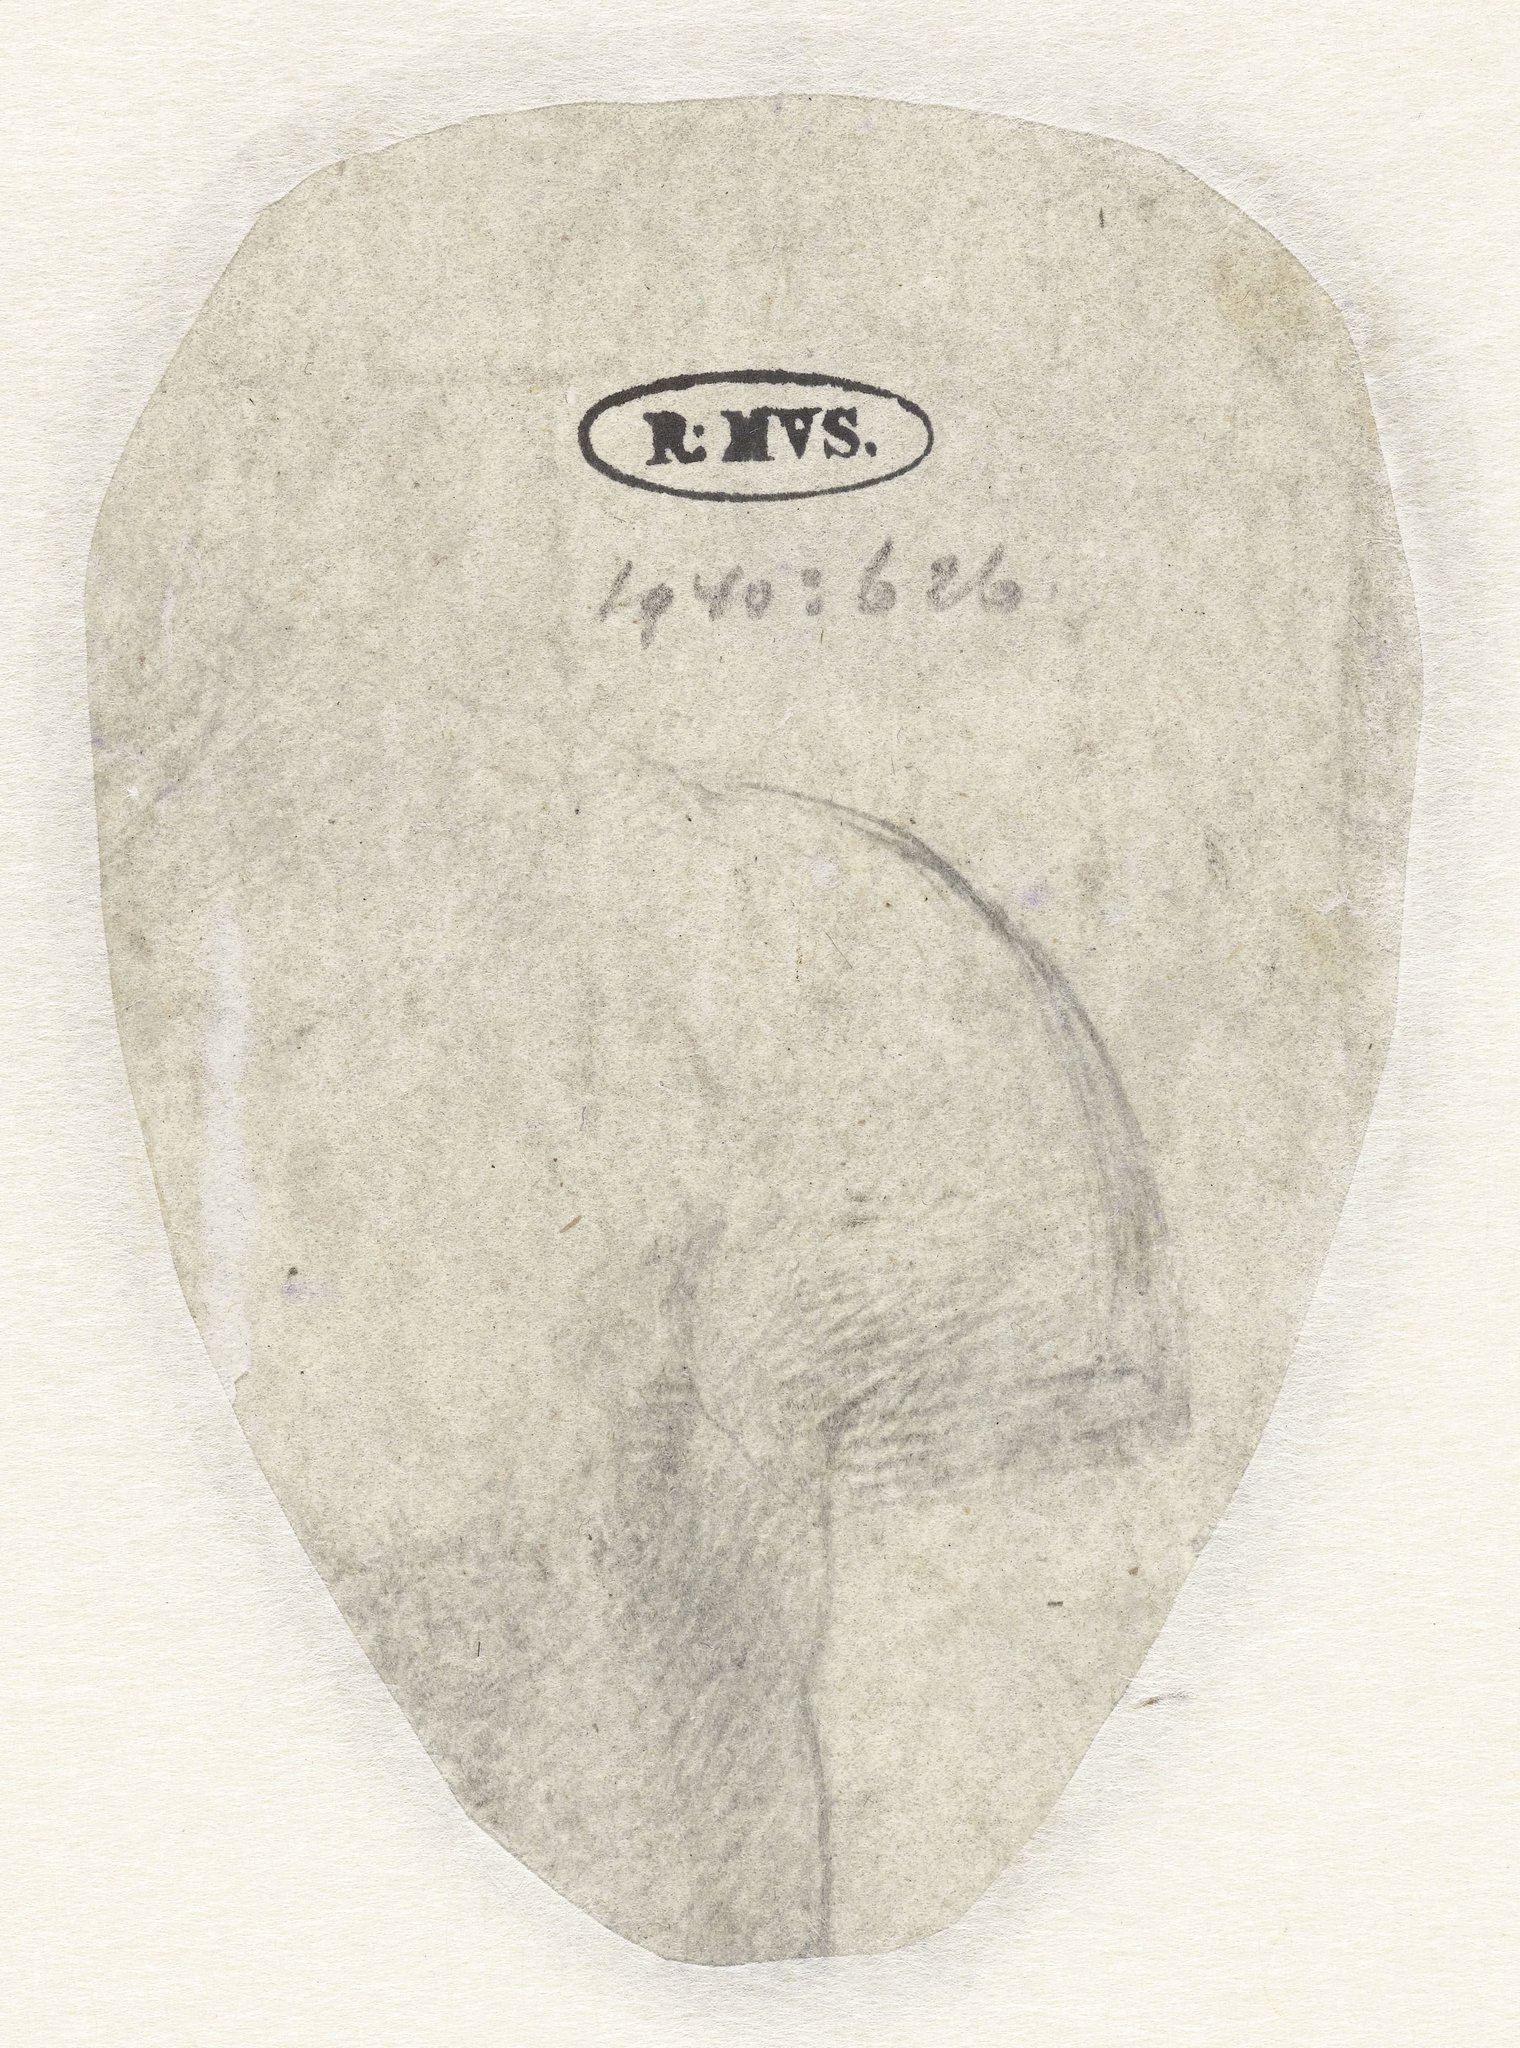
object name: drawing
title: Schets van een schouder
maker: giulio romano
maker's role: draughtsman, painter, print maker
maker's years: 1499-1546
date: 1510-1546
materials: chalk, paper